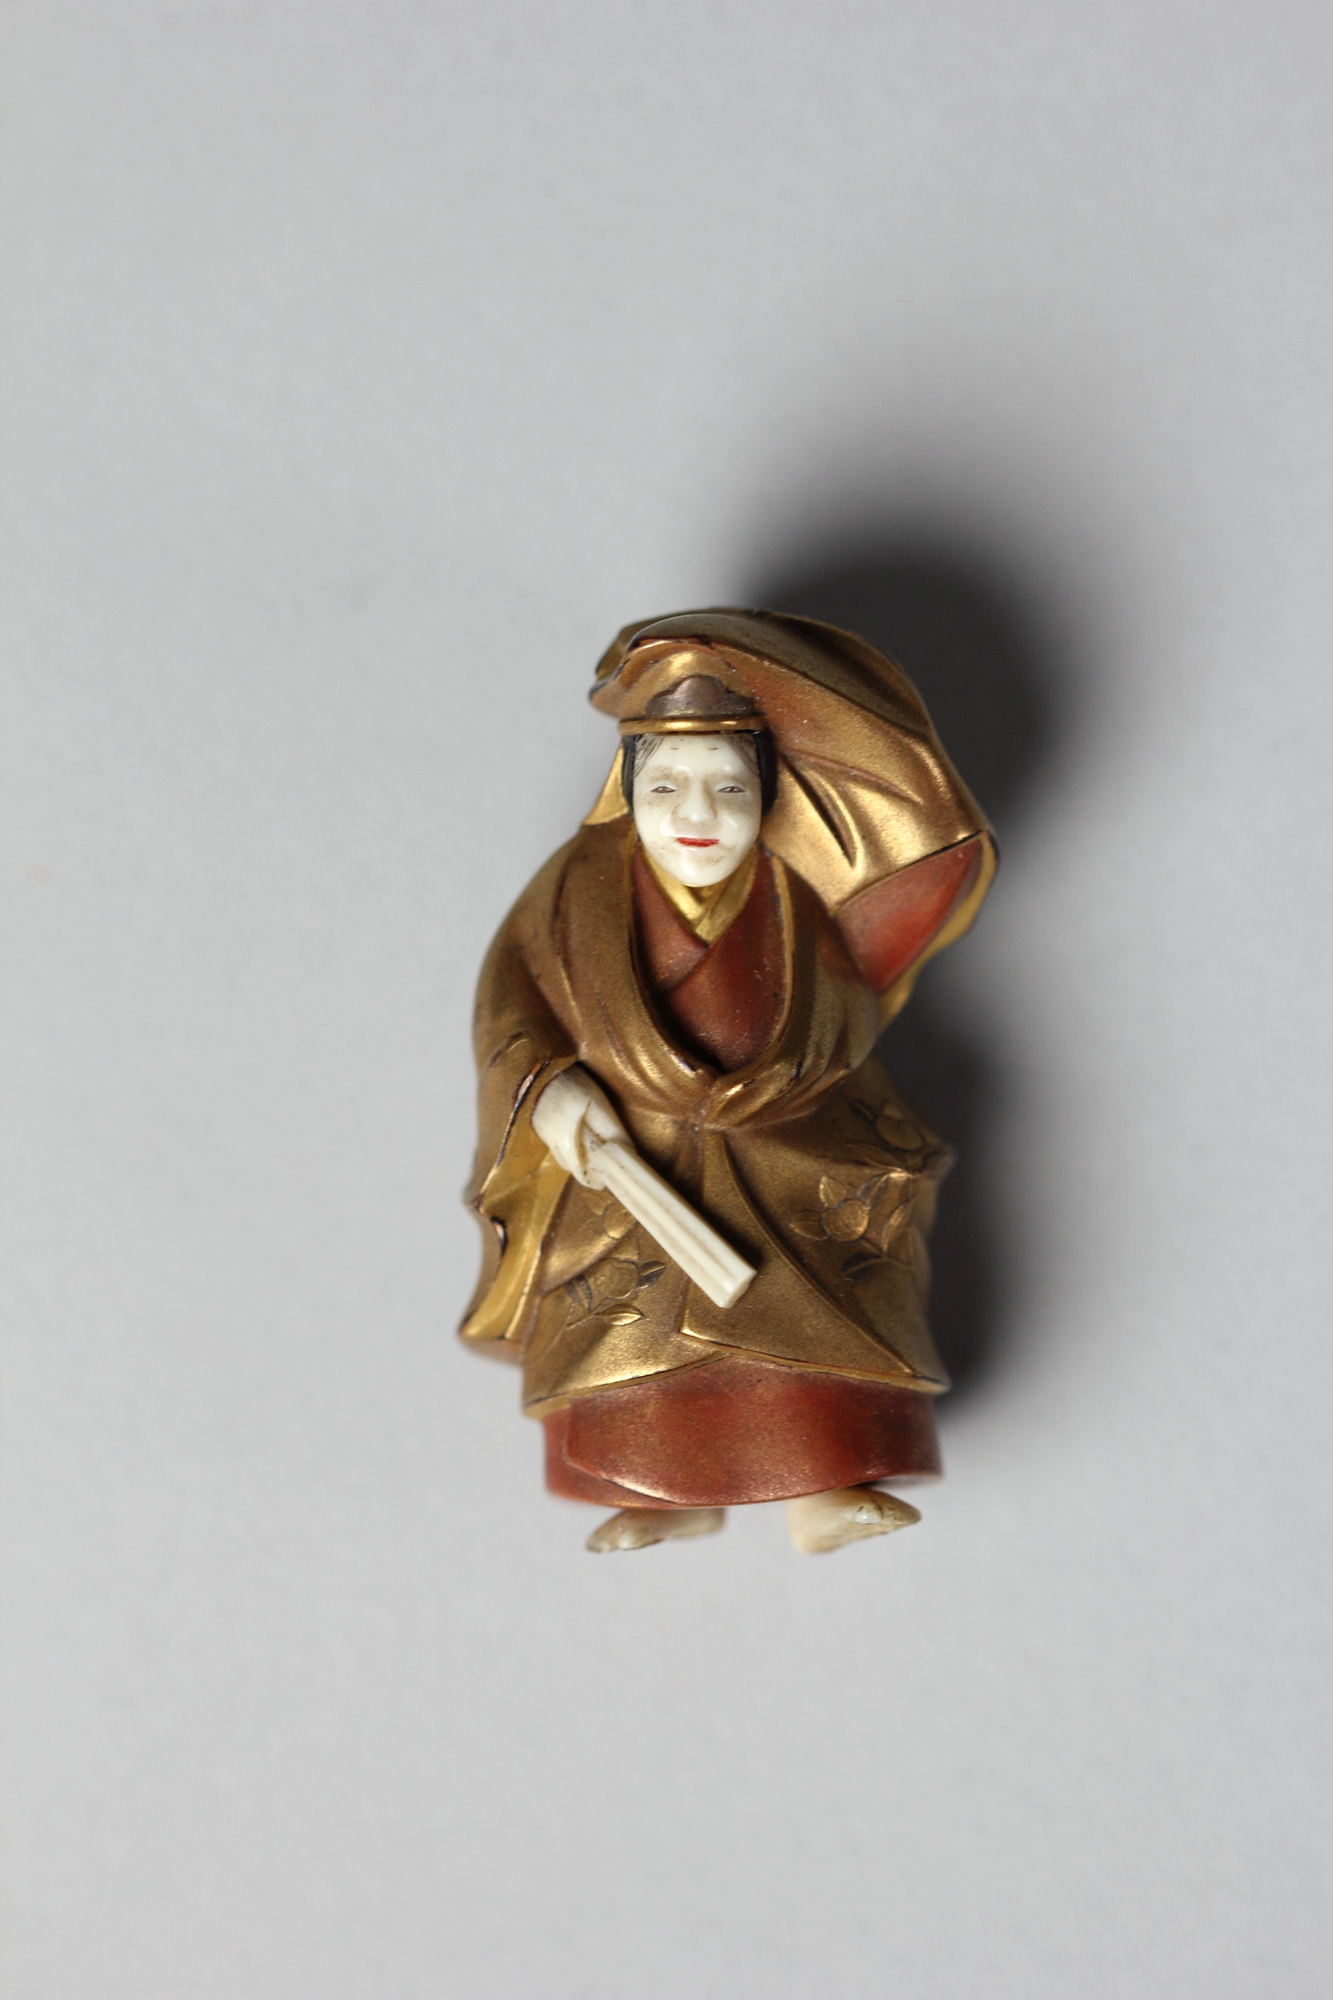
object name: netsuke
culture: japanese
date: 1801-1900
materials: ivory, lacquer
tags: human figures